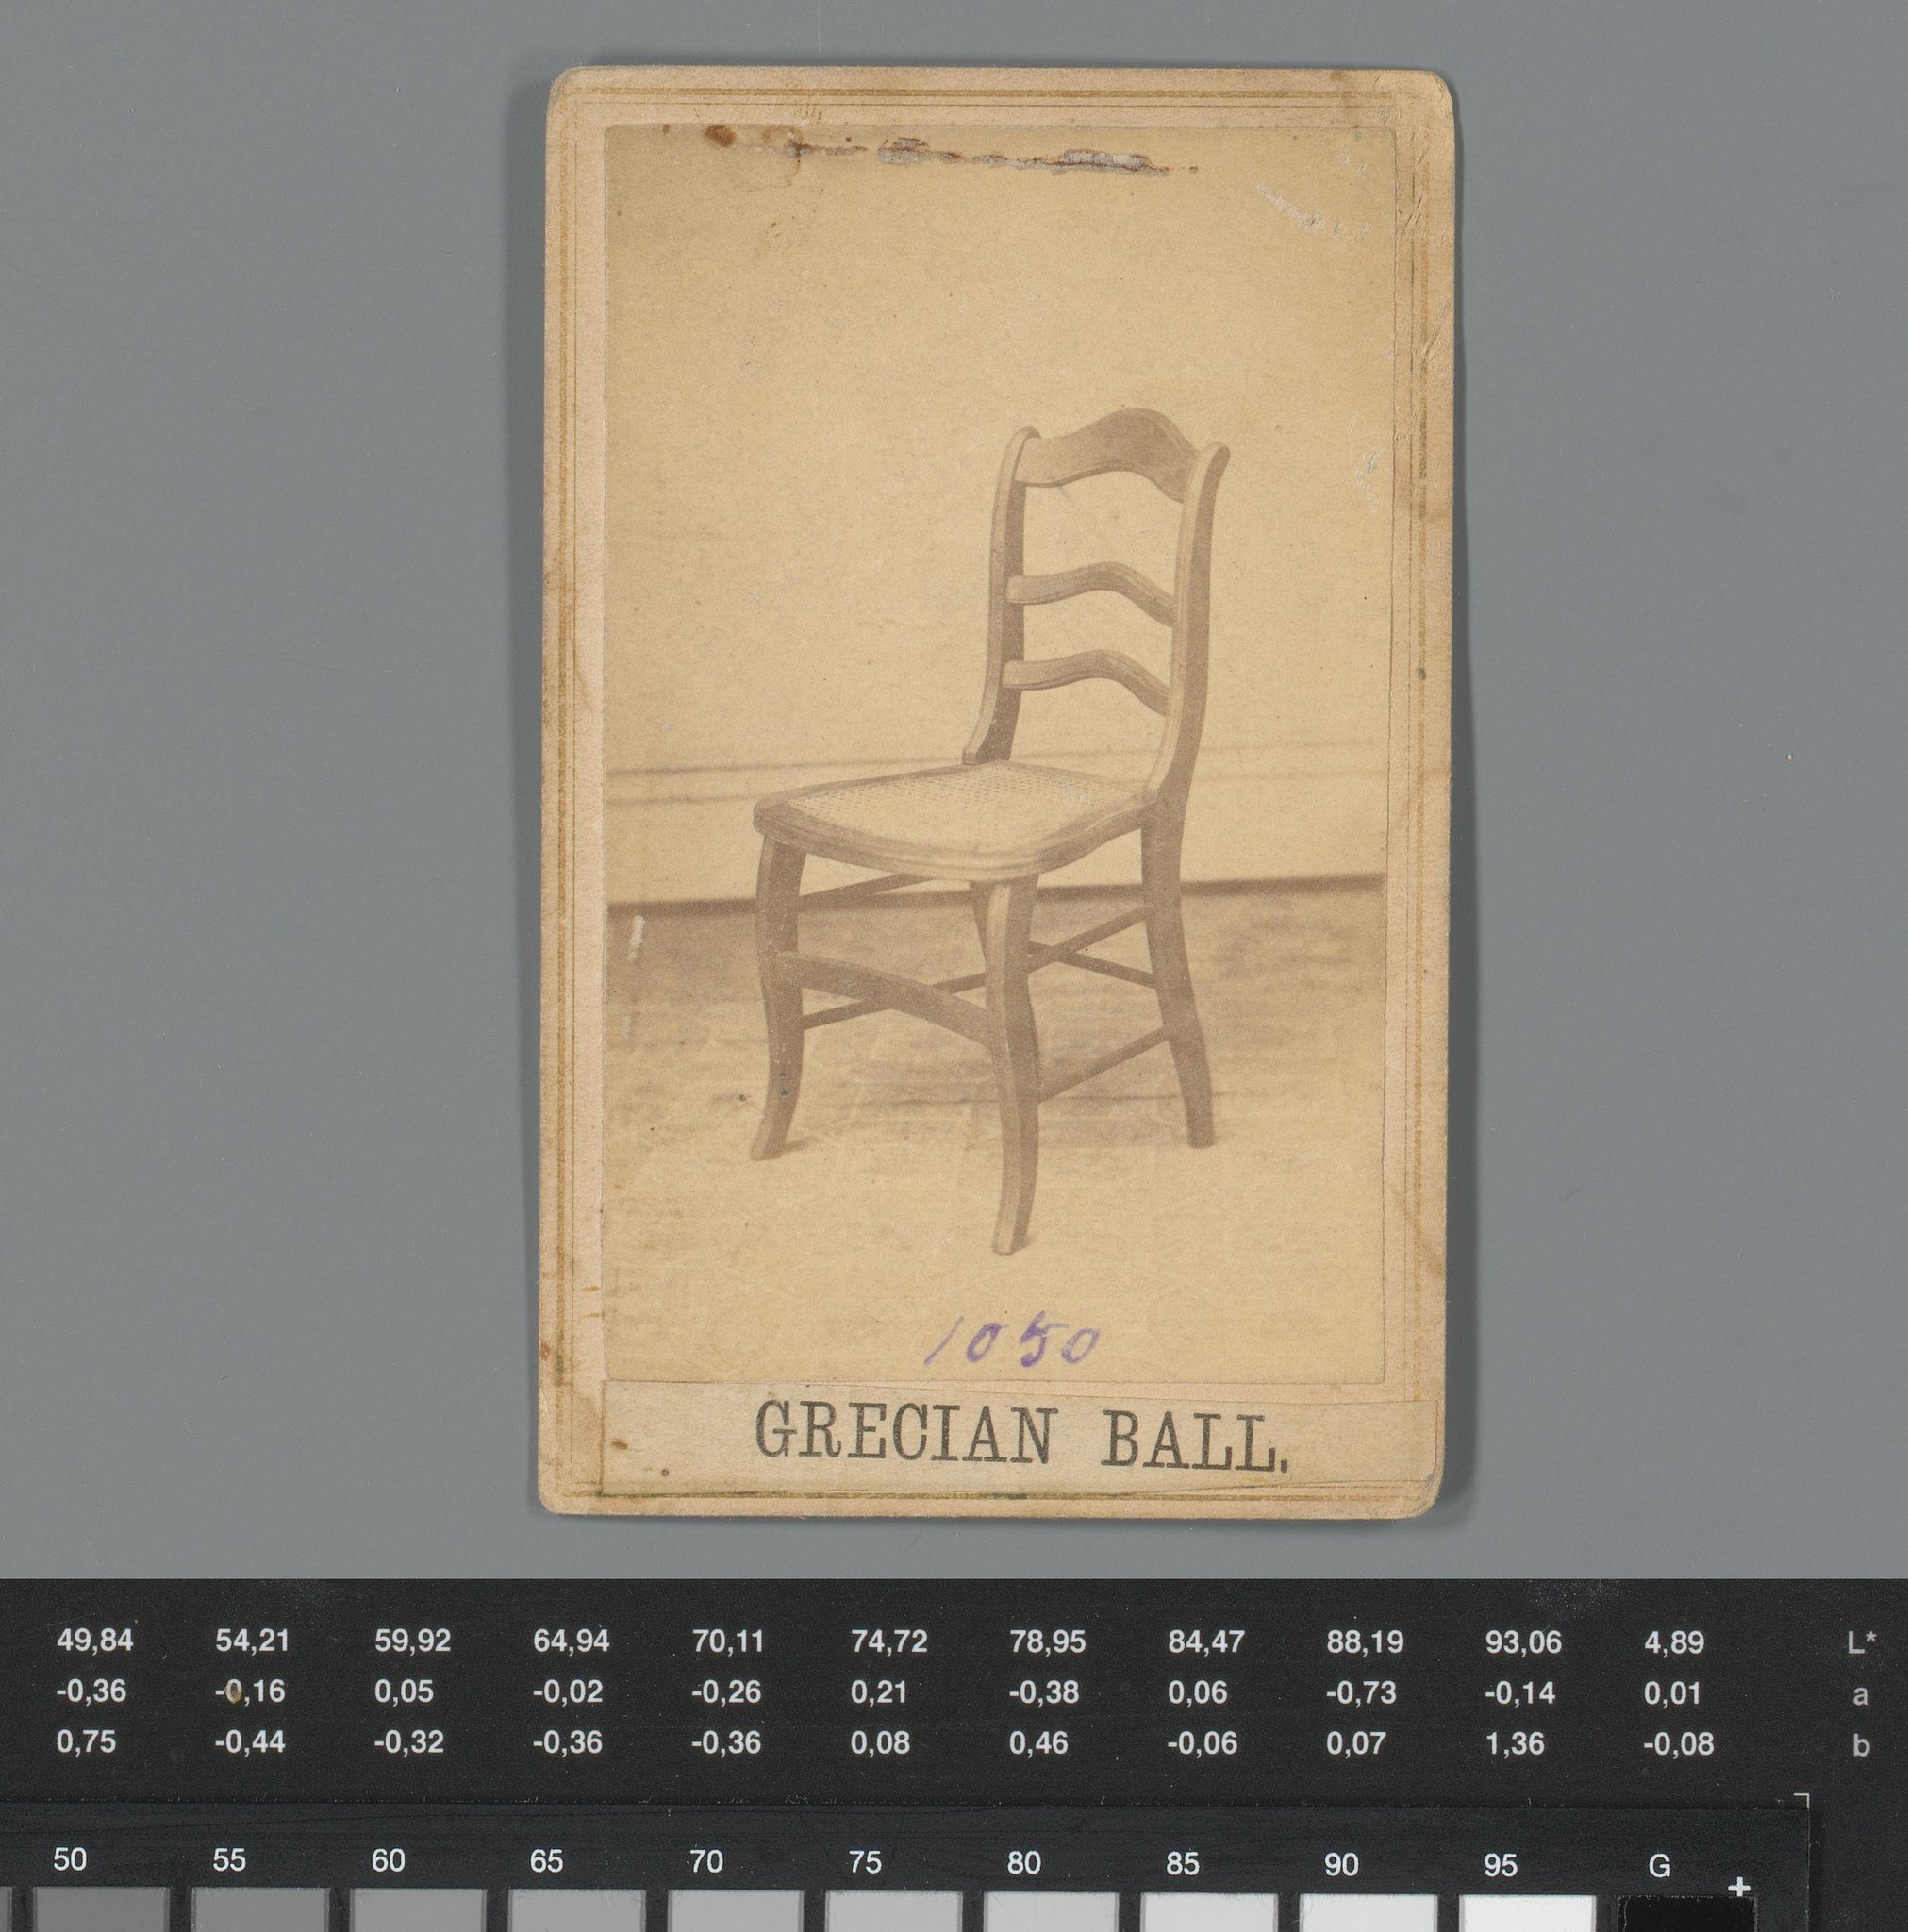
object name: carte de visite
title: Grecian Ball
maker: Anonymous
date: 1850-1915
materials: cardboard, photographic support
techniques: albumen print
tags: advertising, chair